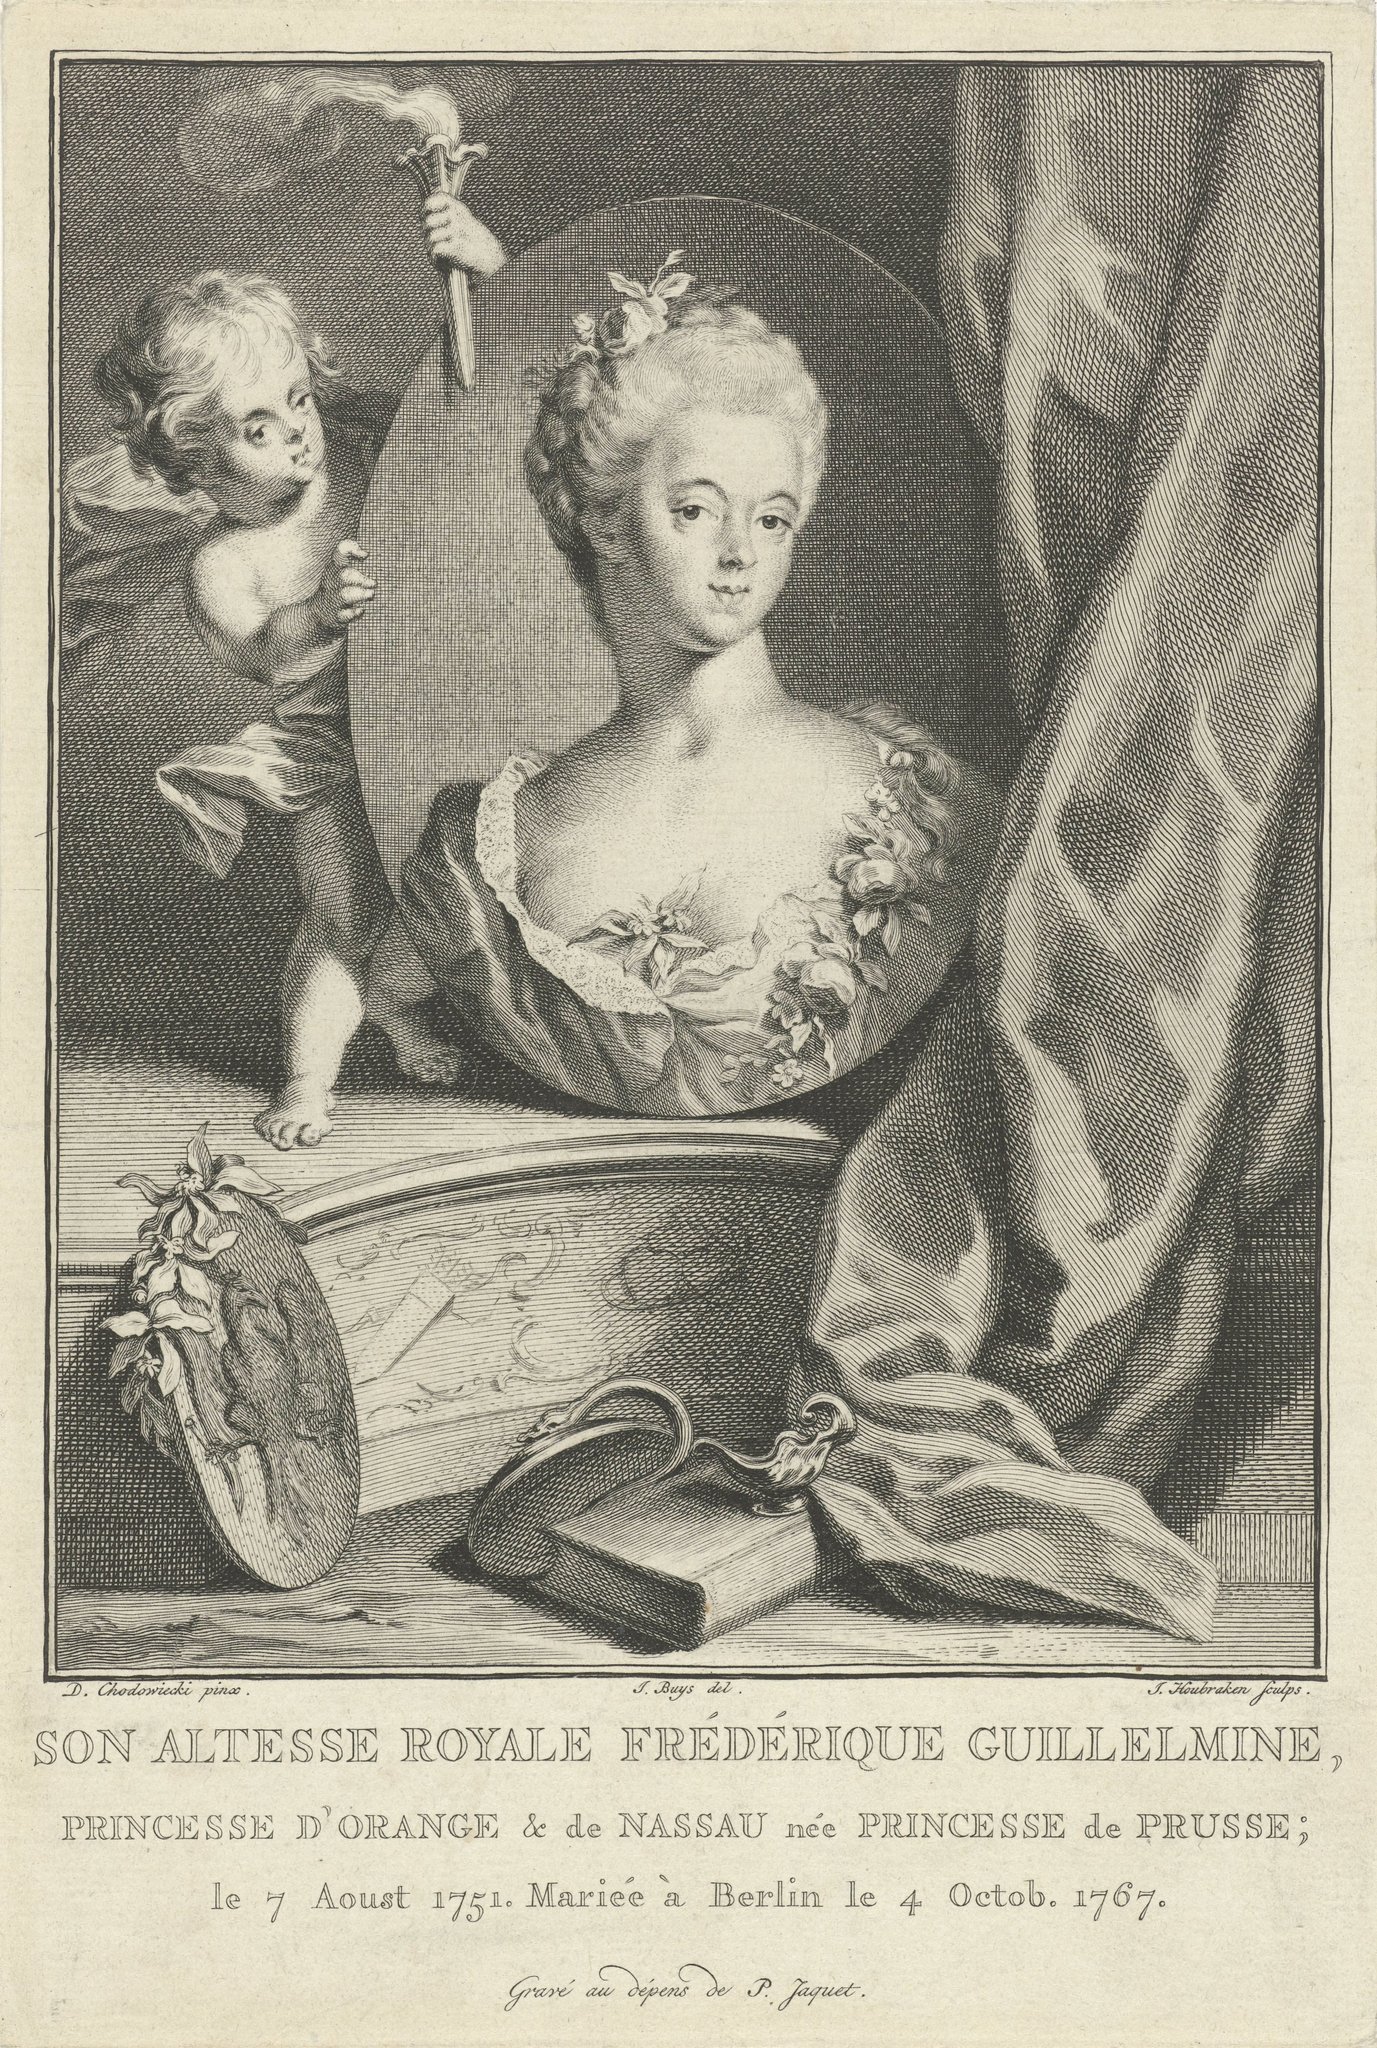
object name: print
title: Portret van Wilhelmina van Pruisen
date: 1767-1769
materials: paper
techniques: engraving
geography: amsterdam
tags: berlin, painter, draughtsman, wilhelmina of prussia (princess of orange), torch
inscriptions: collector's mark: Lugt 2228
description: Portret van Wilhelmina van Pruisen in een ovaal medaillon dat wordt vastgehouden door een putto met een fakkel.